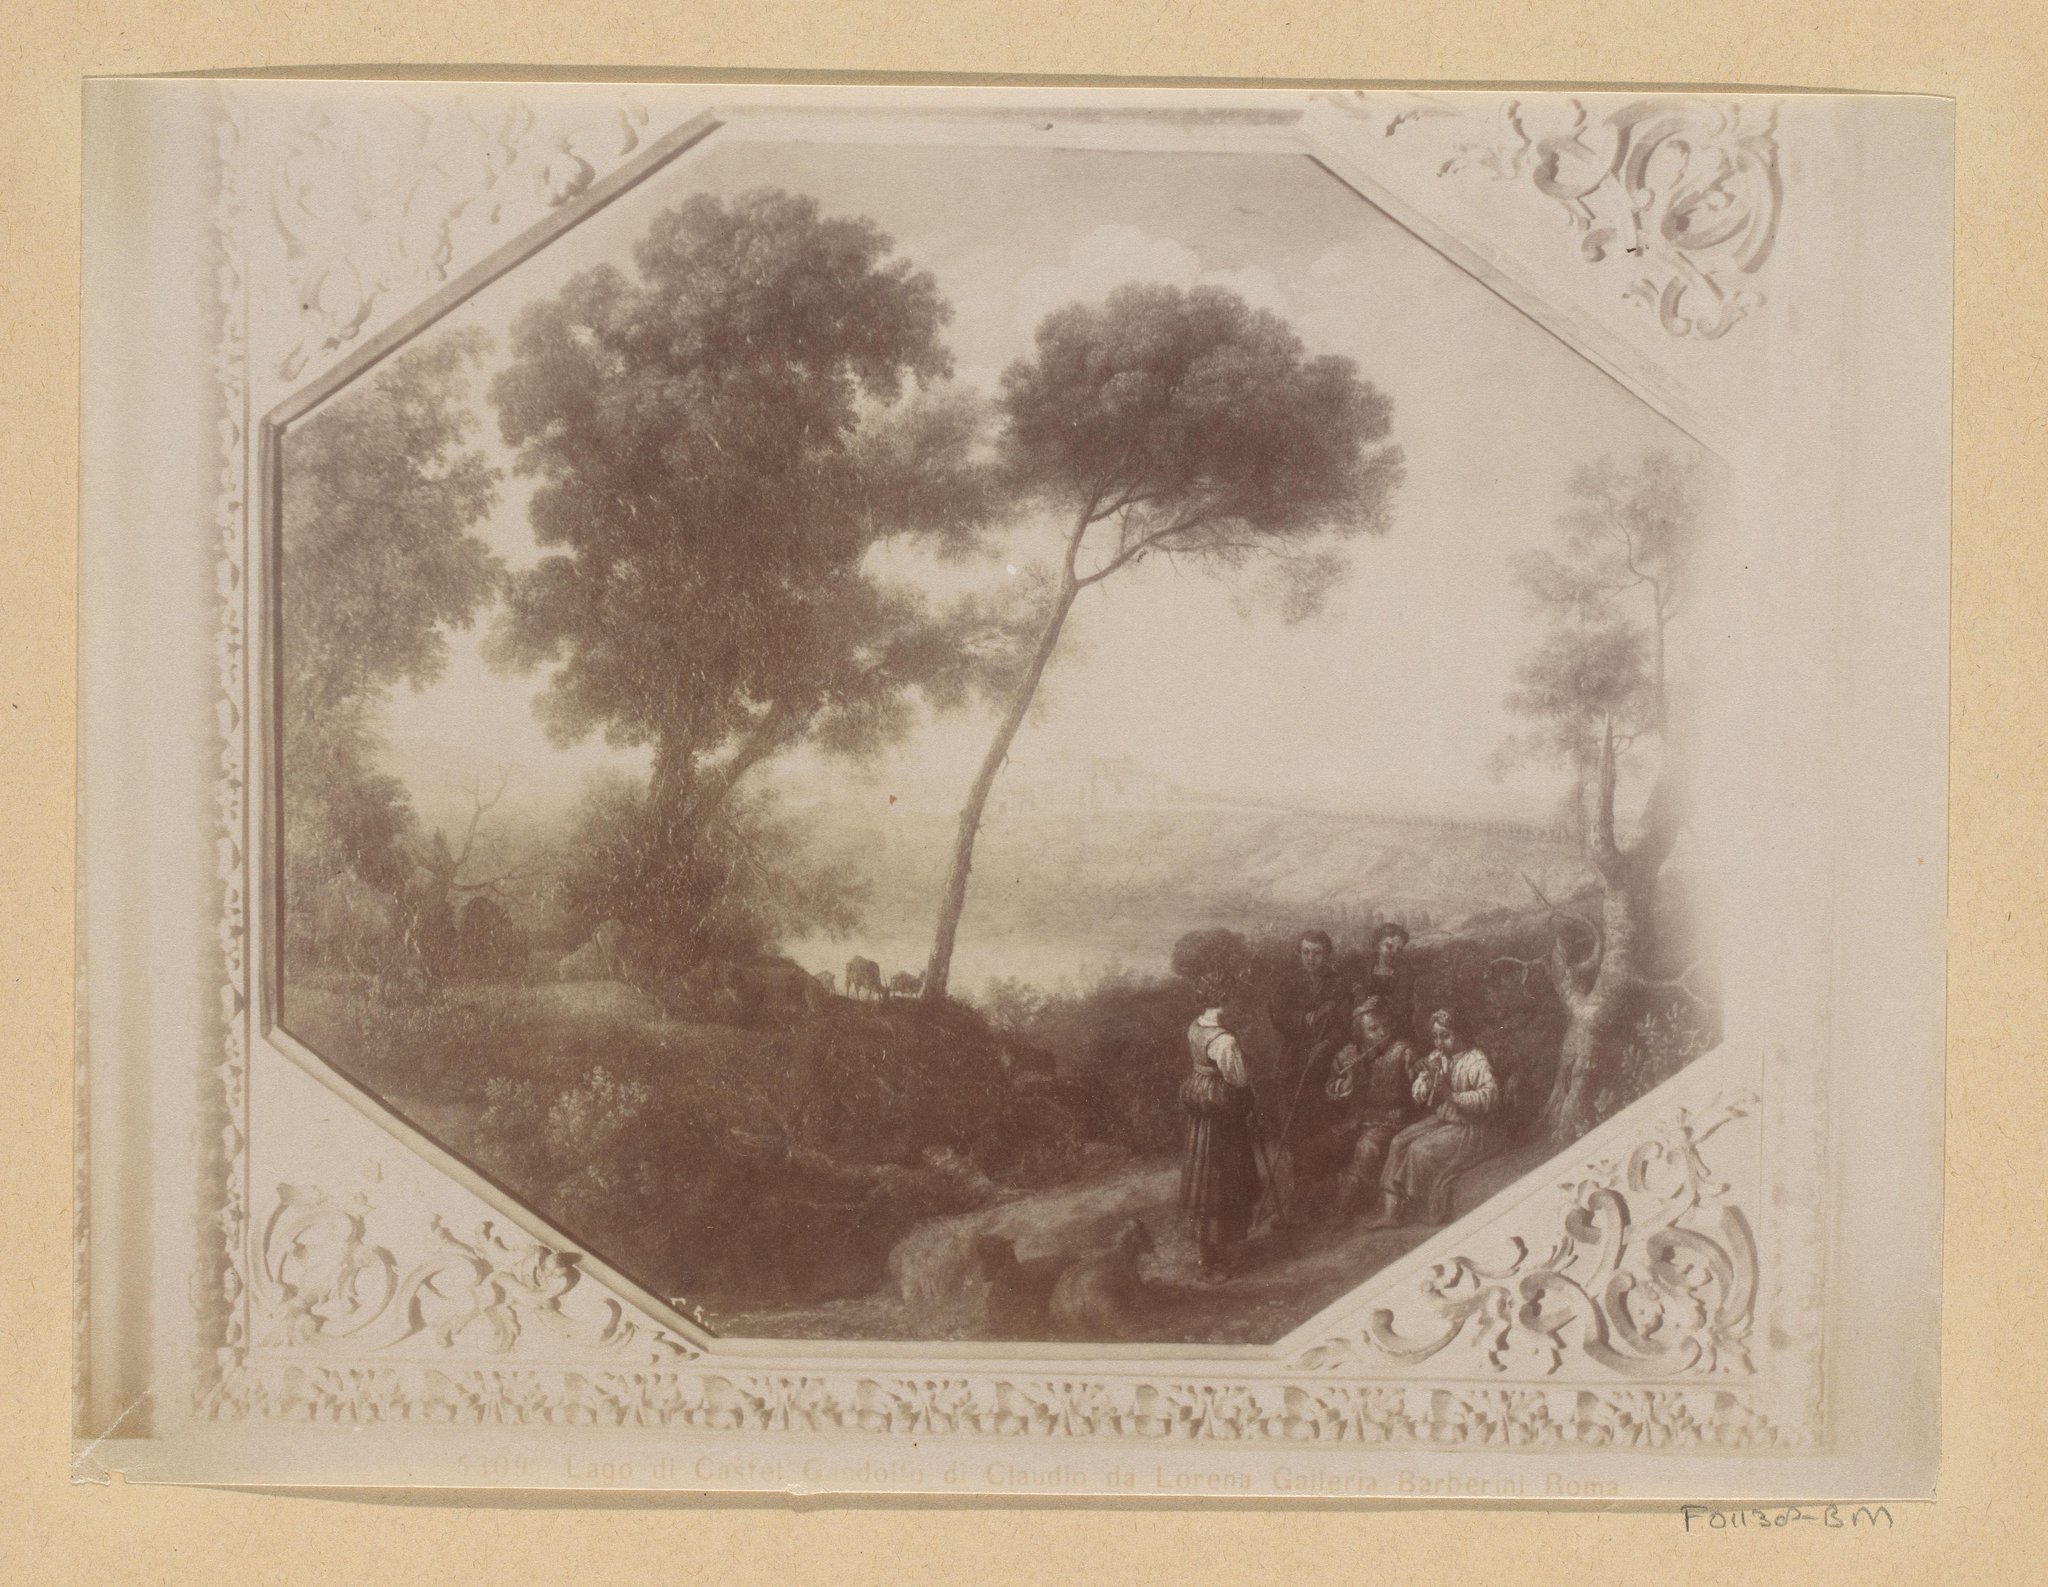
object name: reproduction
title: Lago di Castel Gandolfo di Claudio da Lorena, Galleria Barberini Roma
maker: Anonymous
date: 1860-1900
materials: photographic support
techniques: albumen print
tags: landscapes in tropical and sub-tropical regions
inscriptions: number: ‘5309’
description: Onderdeel van Reisalbum met opnames van kunstwerken en bezienswaardigheden in Italië, Griekenland en Frankrijk.